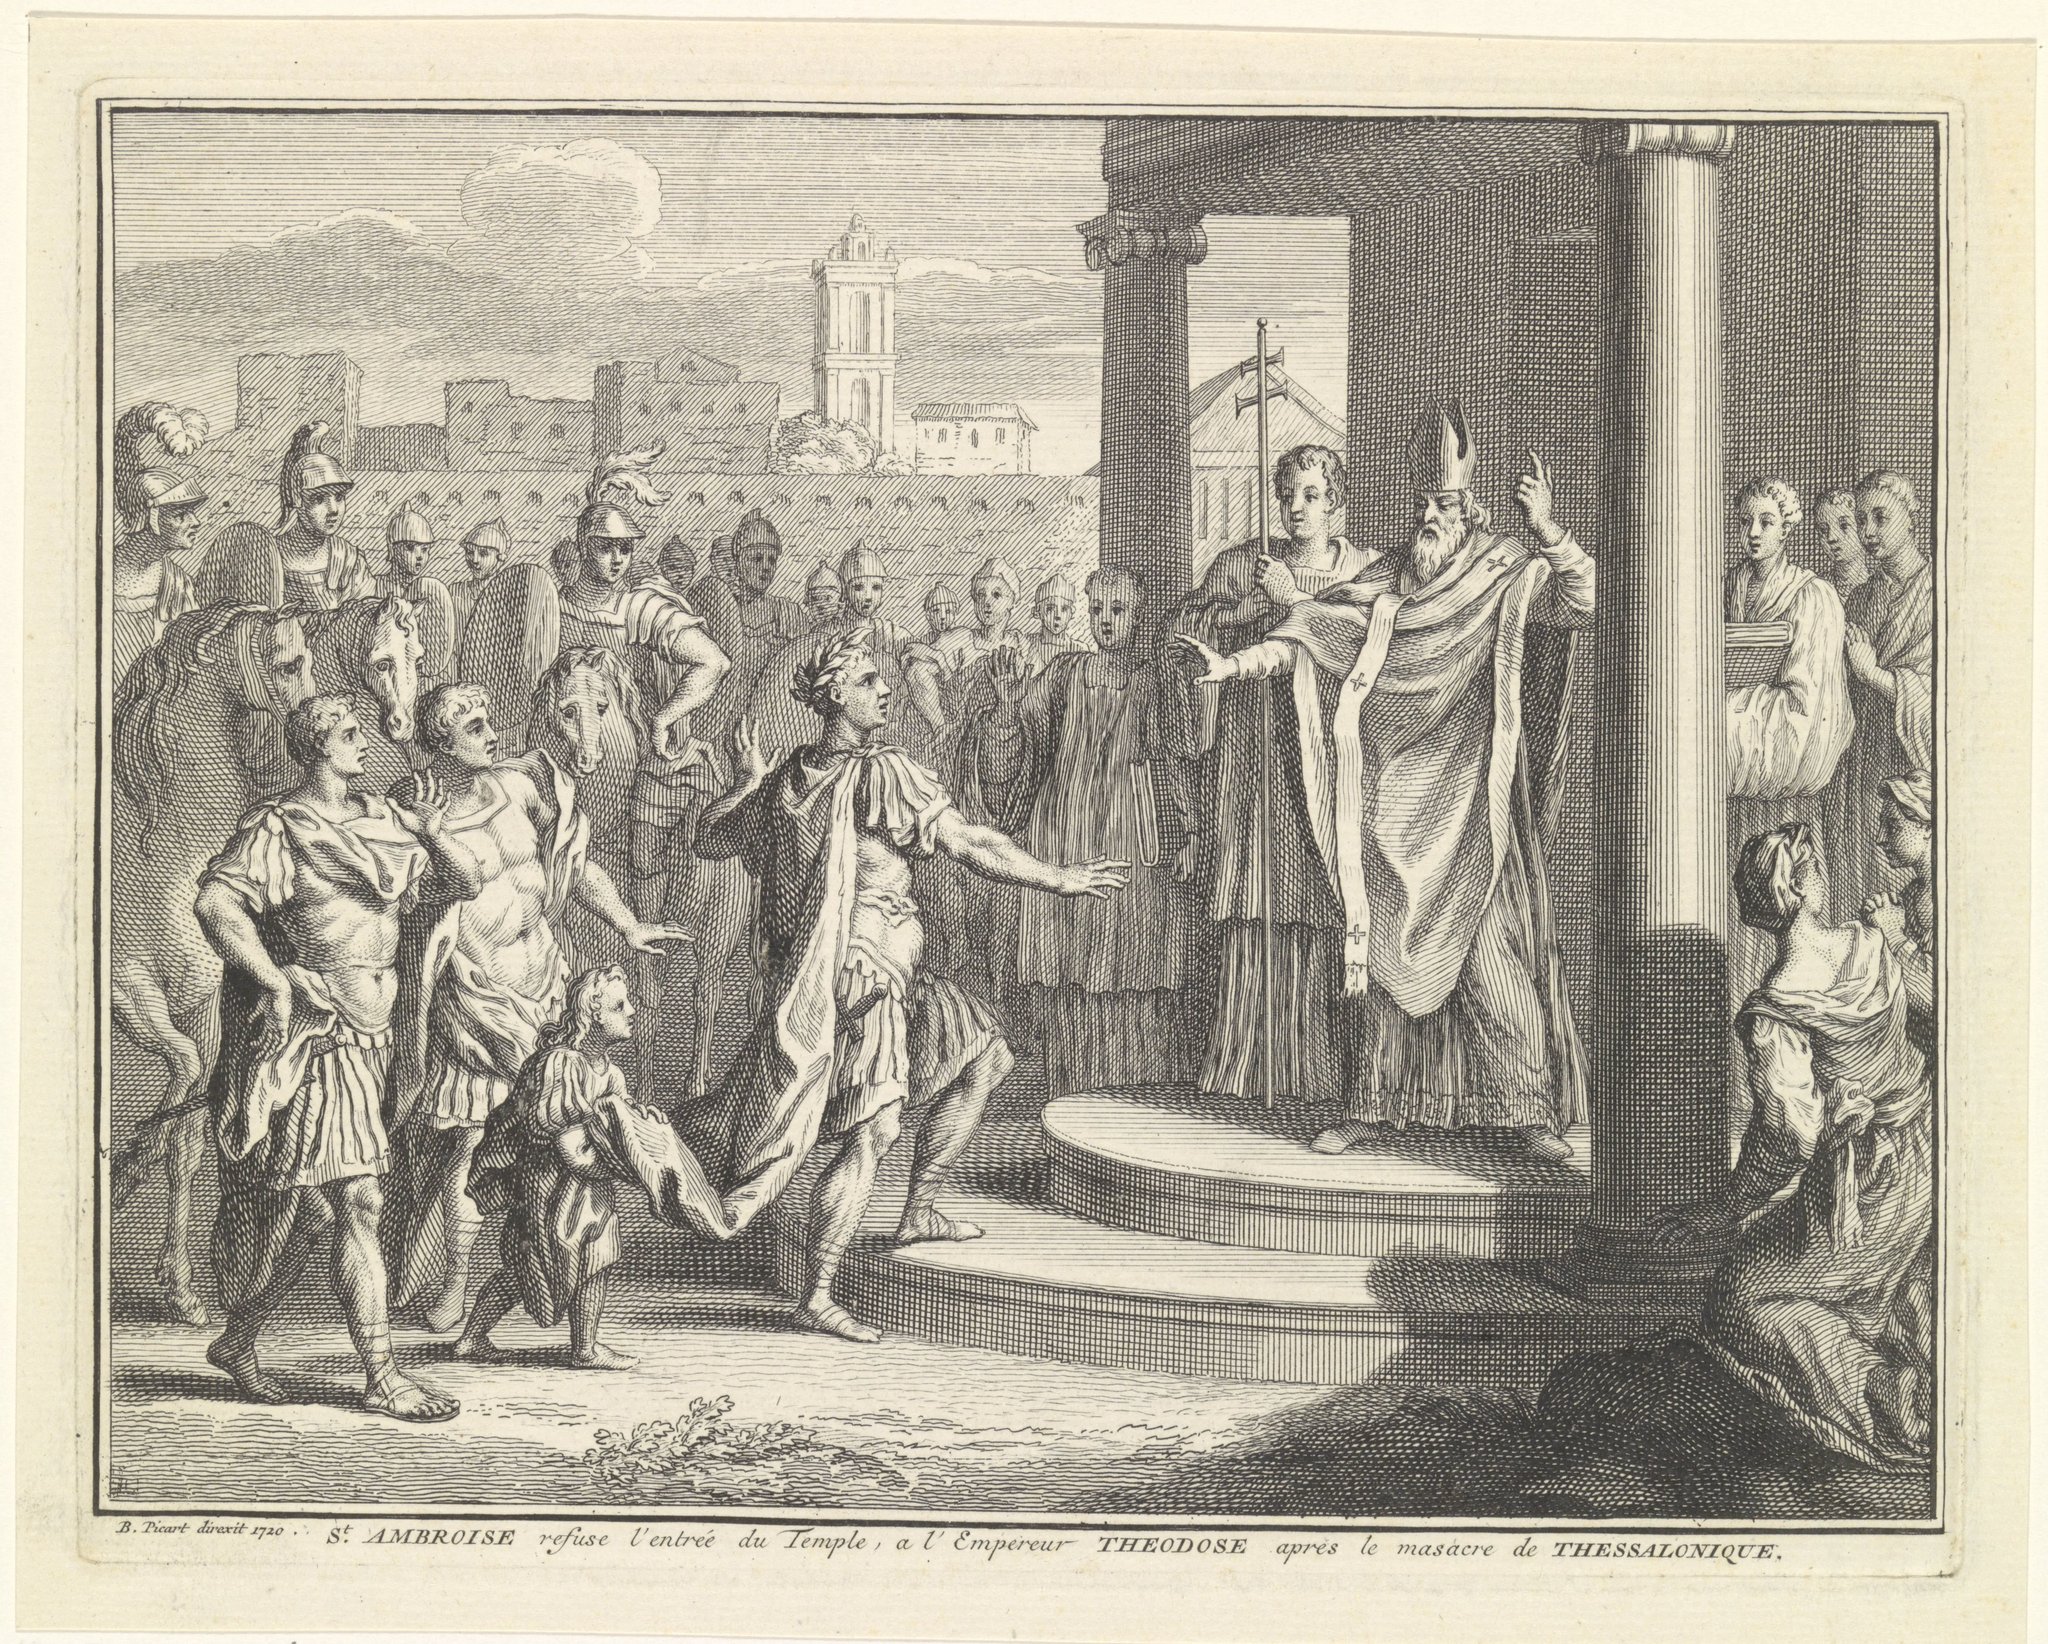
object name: book illustration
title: H. Ambrosius weigert Theodosius I de toegang tot de kerk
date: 1720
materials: paper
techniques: engraving, etching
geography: amsterdam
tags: ambrose, bishop of milan; possible attributes: beehive, cradle with baby, three-knotted scourge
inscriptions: date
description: De heilige Ambrosius weigert keizer Theodosius I de toegang tot de kerk van Milaan, omdat hij in de Griekse stad Thessaloniki duizenden mensen had laten afslachten. In de marge een onderschrift in het Frans.